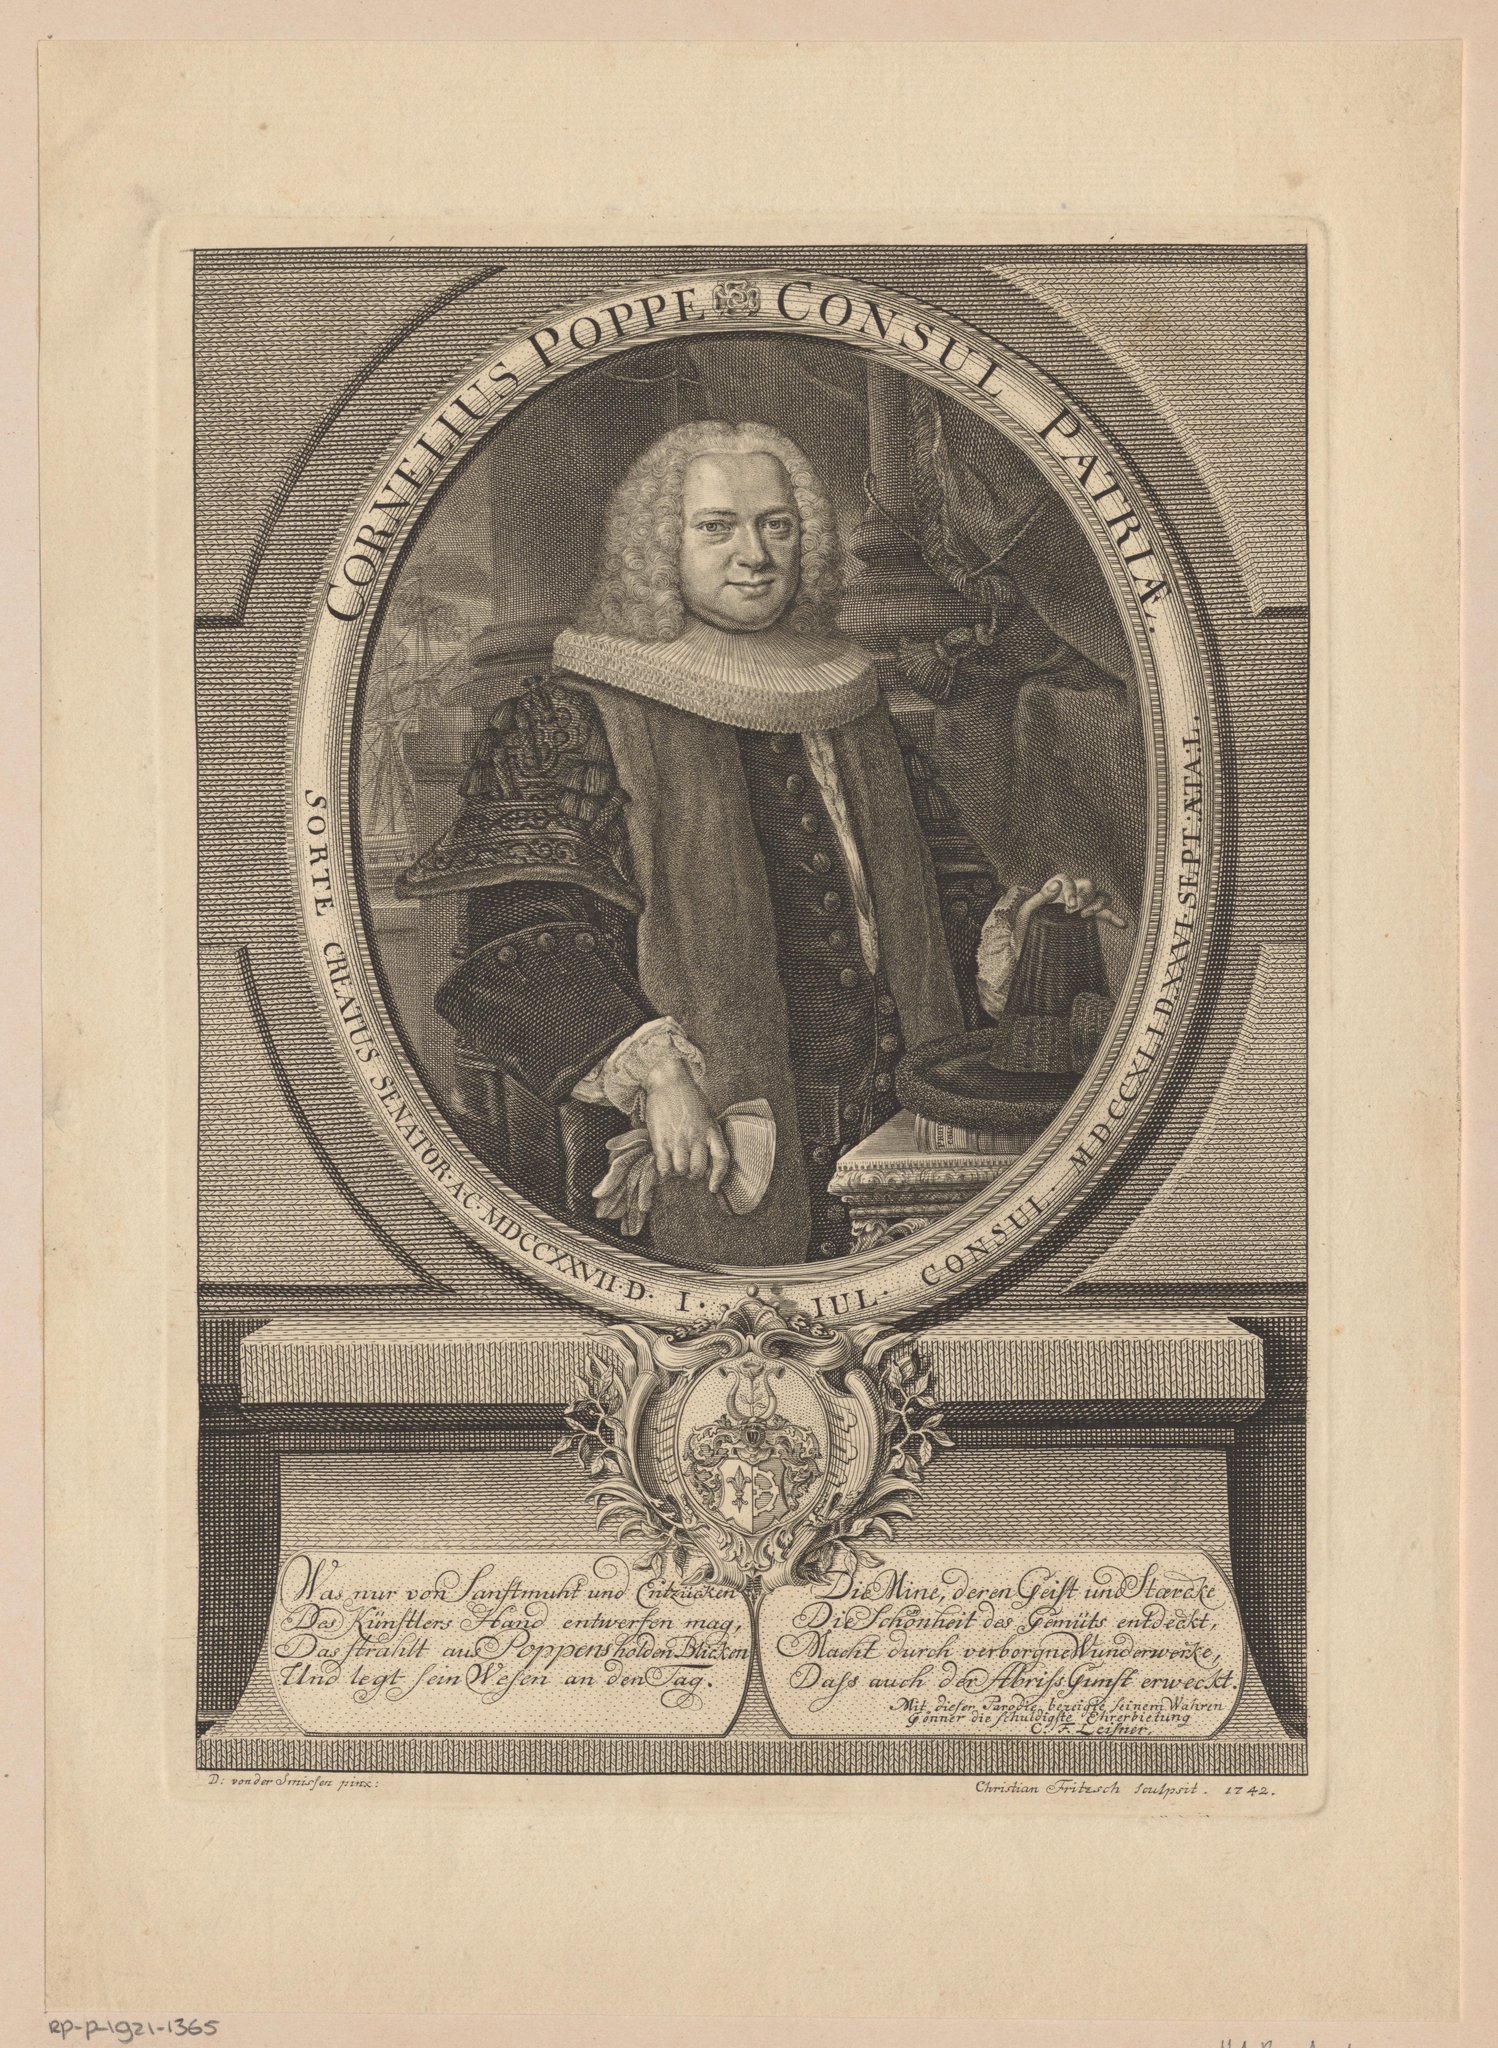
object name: print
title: Portret van Cornelius Poppe op 50-jarige leeftijd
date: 1742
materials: paper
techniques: engraving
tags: mayor, mayor, burgomaster, gloves, mittens, etc., historical persons, armorial bearing, heraldry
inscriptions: collector's mark: Lugt 2233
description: Met achtregelig onderschrift in twee kolommen in het Duits.